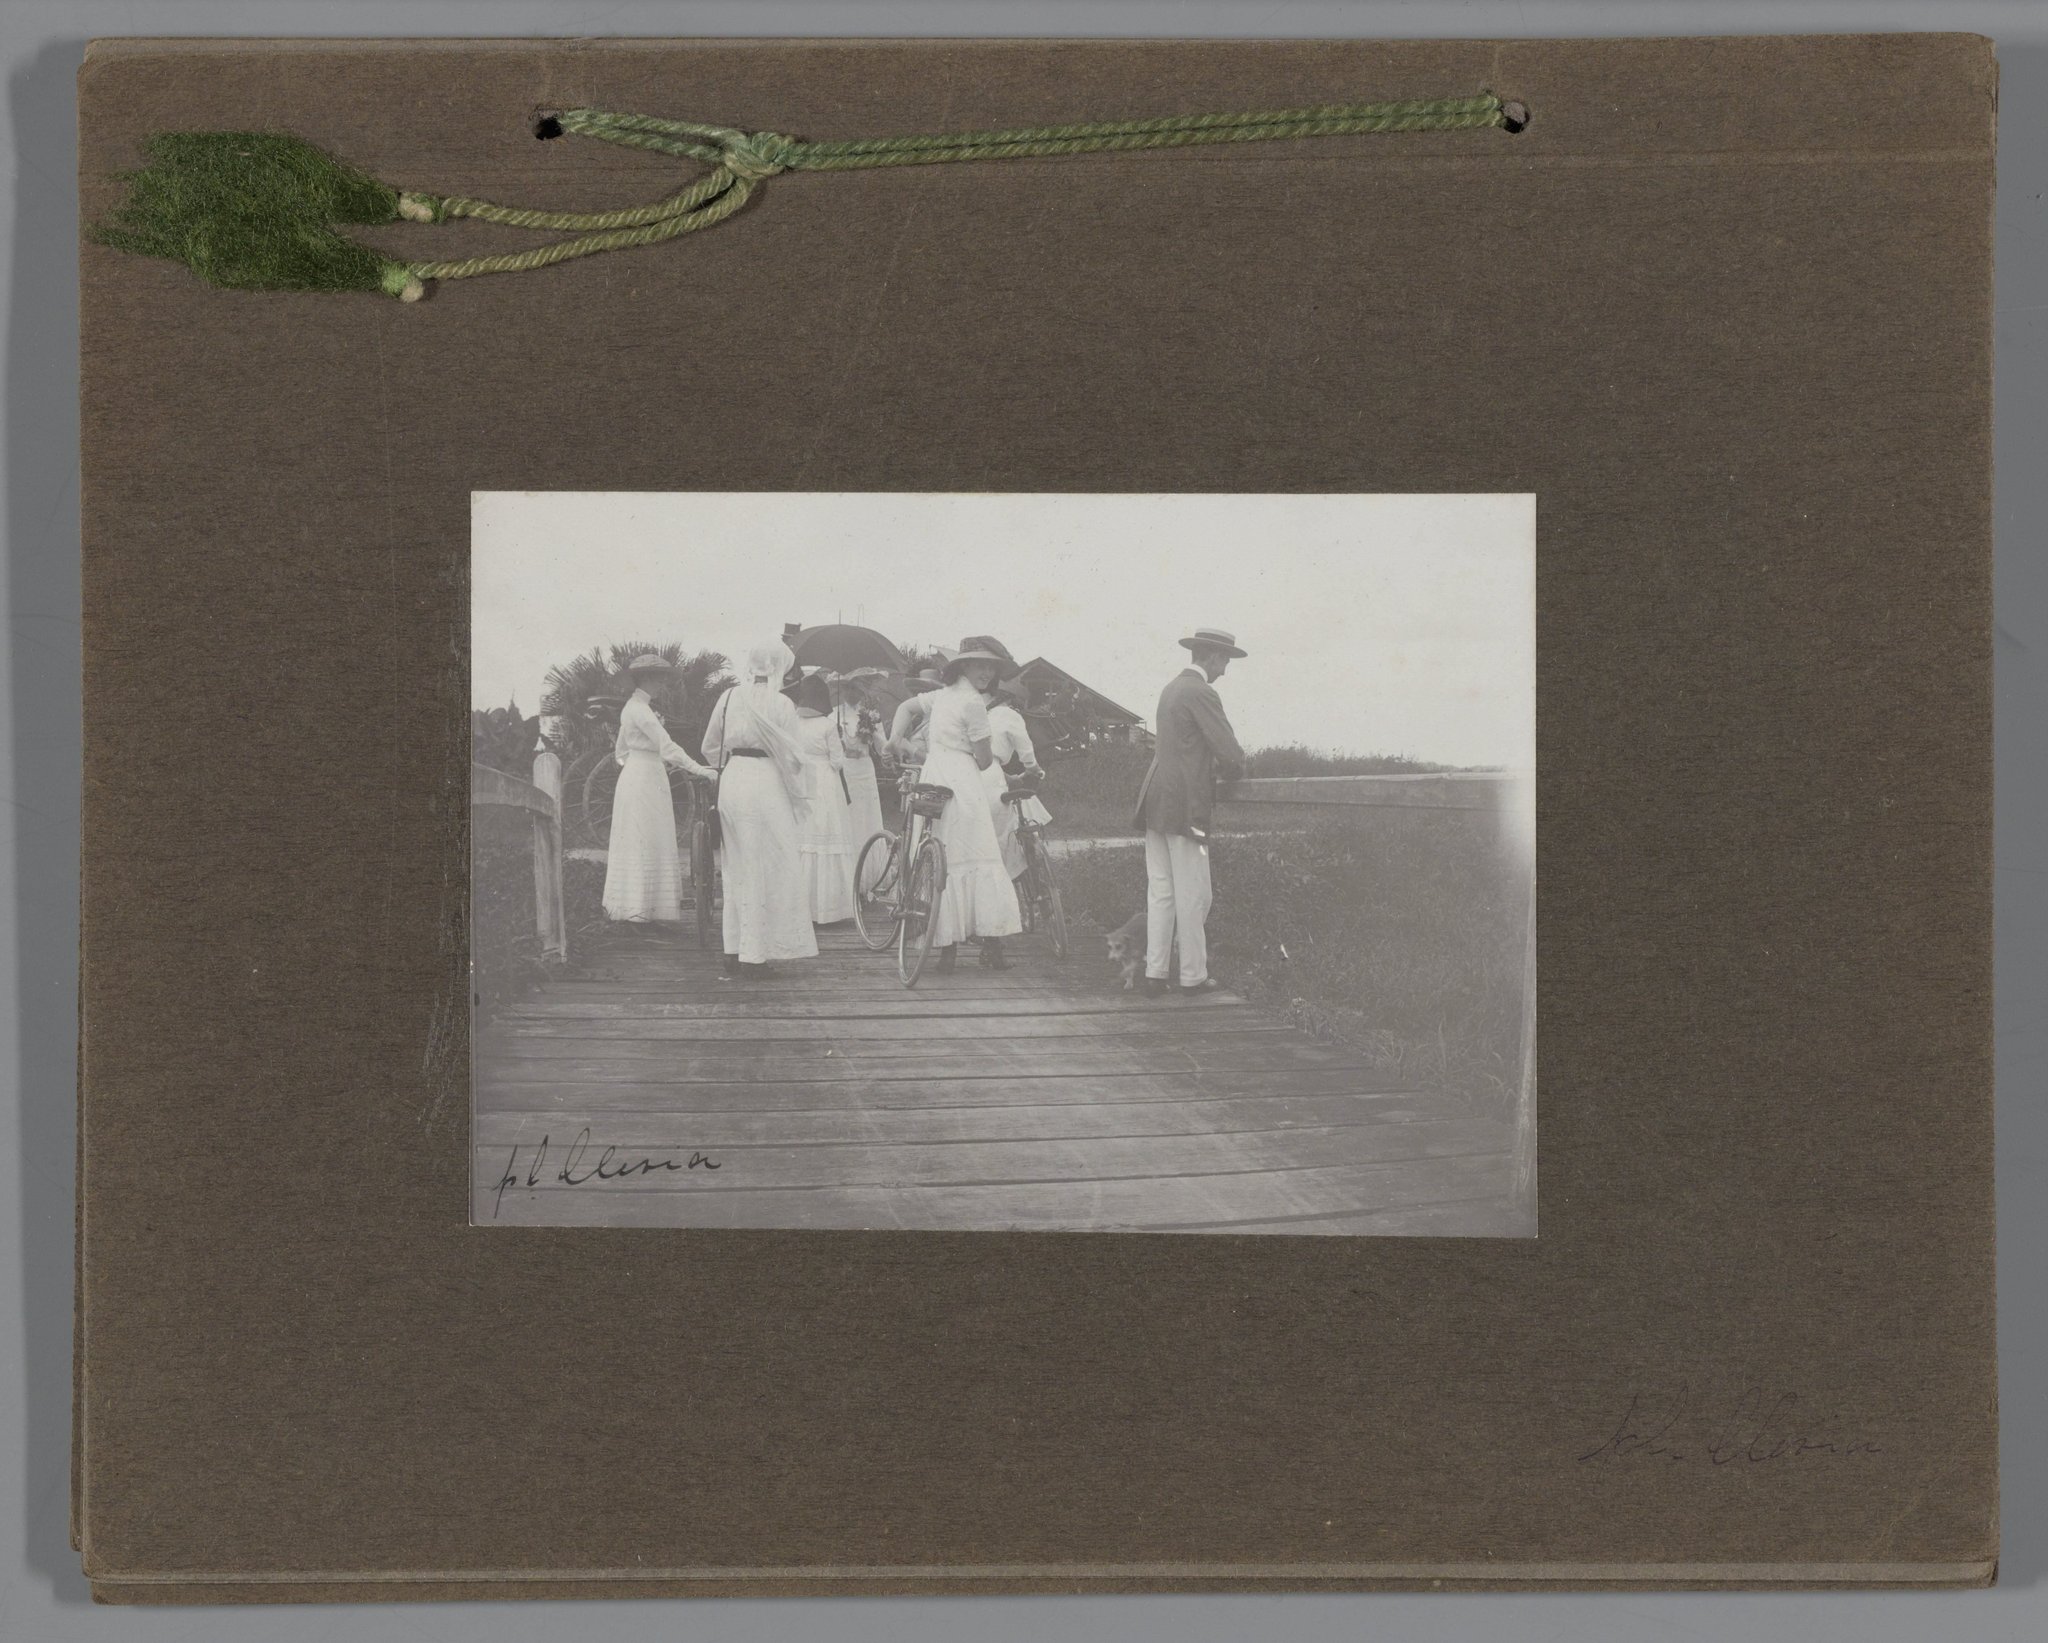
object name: photograph album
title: Fotoalbum van elf losse bladen over de familie Gonggrijp in Suriname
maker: Anonymous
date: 1910-1914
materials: cardboard, photographic support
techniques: photography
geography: suriname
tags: suriname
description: Elf losse albumbladen van bruin karton zonder band, bij elkaar gehouden met een touwtje, met 19 foto's van een bezoek van de familie Gonggrijp aan een nederzetting van nazaten van de oorspronkelijke bevolking van Suriname bij Albina, tennis op de tennisbaan van Paramaribo, stadsgezichten van Paramaribo en gezichten op de plantages Clevia en Alliance. Tevens familiefoto's en foto's van een bezoek aan Albina en Frans-Guyana. Enkele foto's gedateerd 1912.